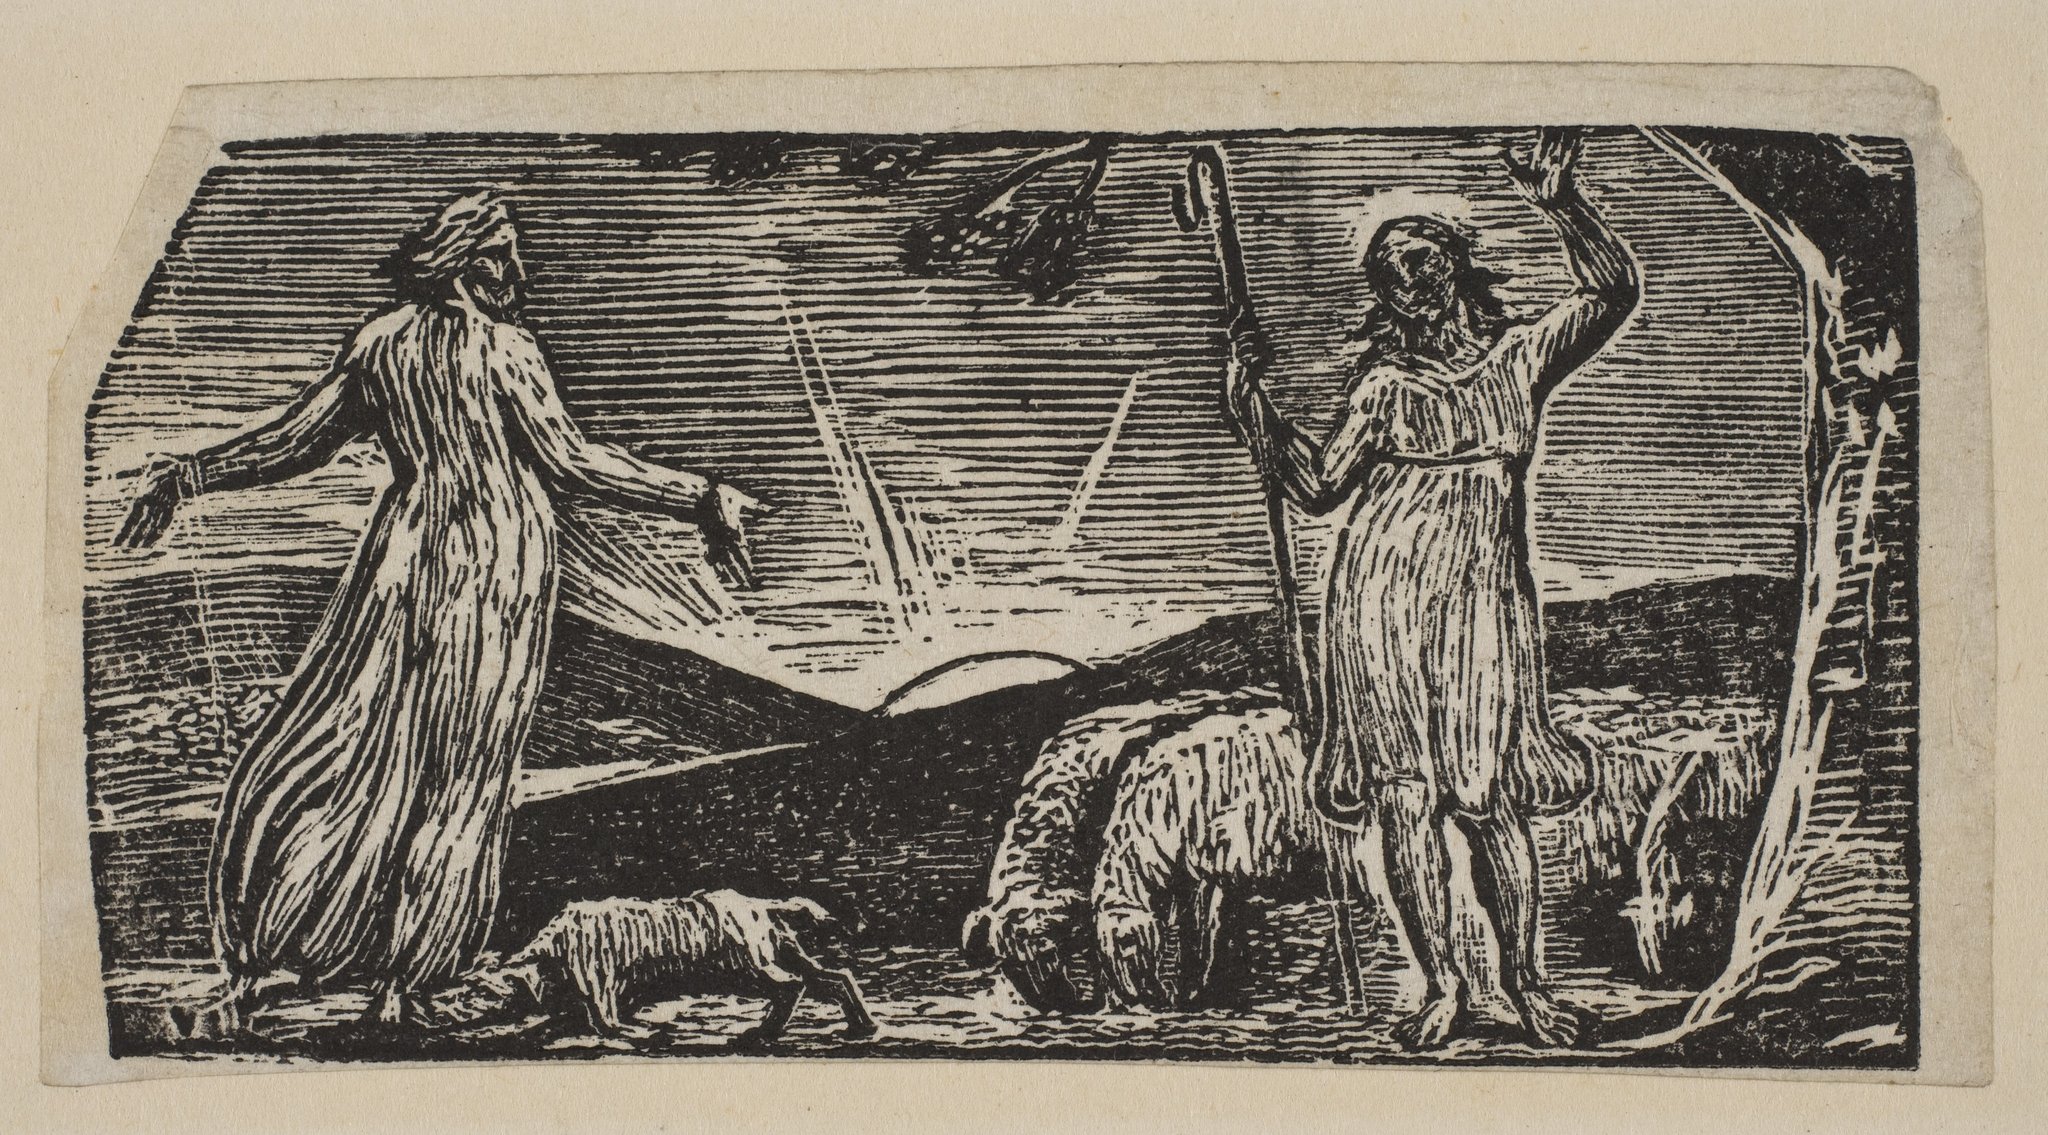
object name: print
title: Thenot Remonstrates With Colinet, from Thornton's "Pastorals of Virgil"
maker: william blake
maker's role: artist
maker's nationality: british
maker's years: 1757-1827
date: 1821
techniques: engraving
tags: men,women,sheep